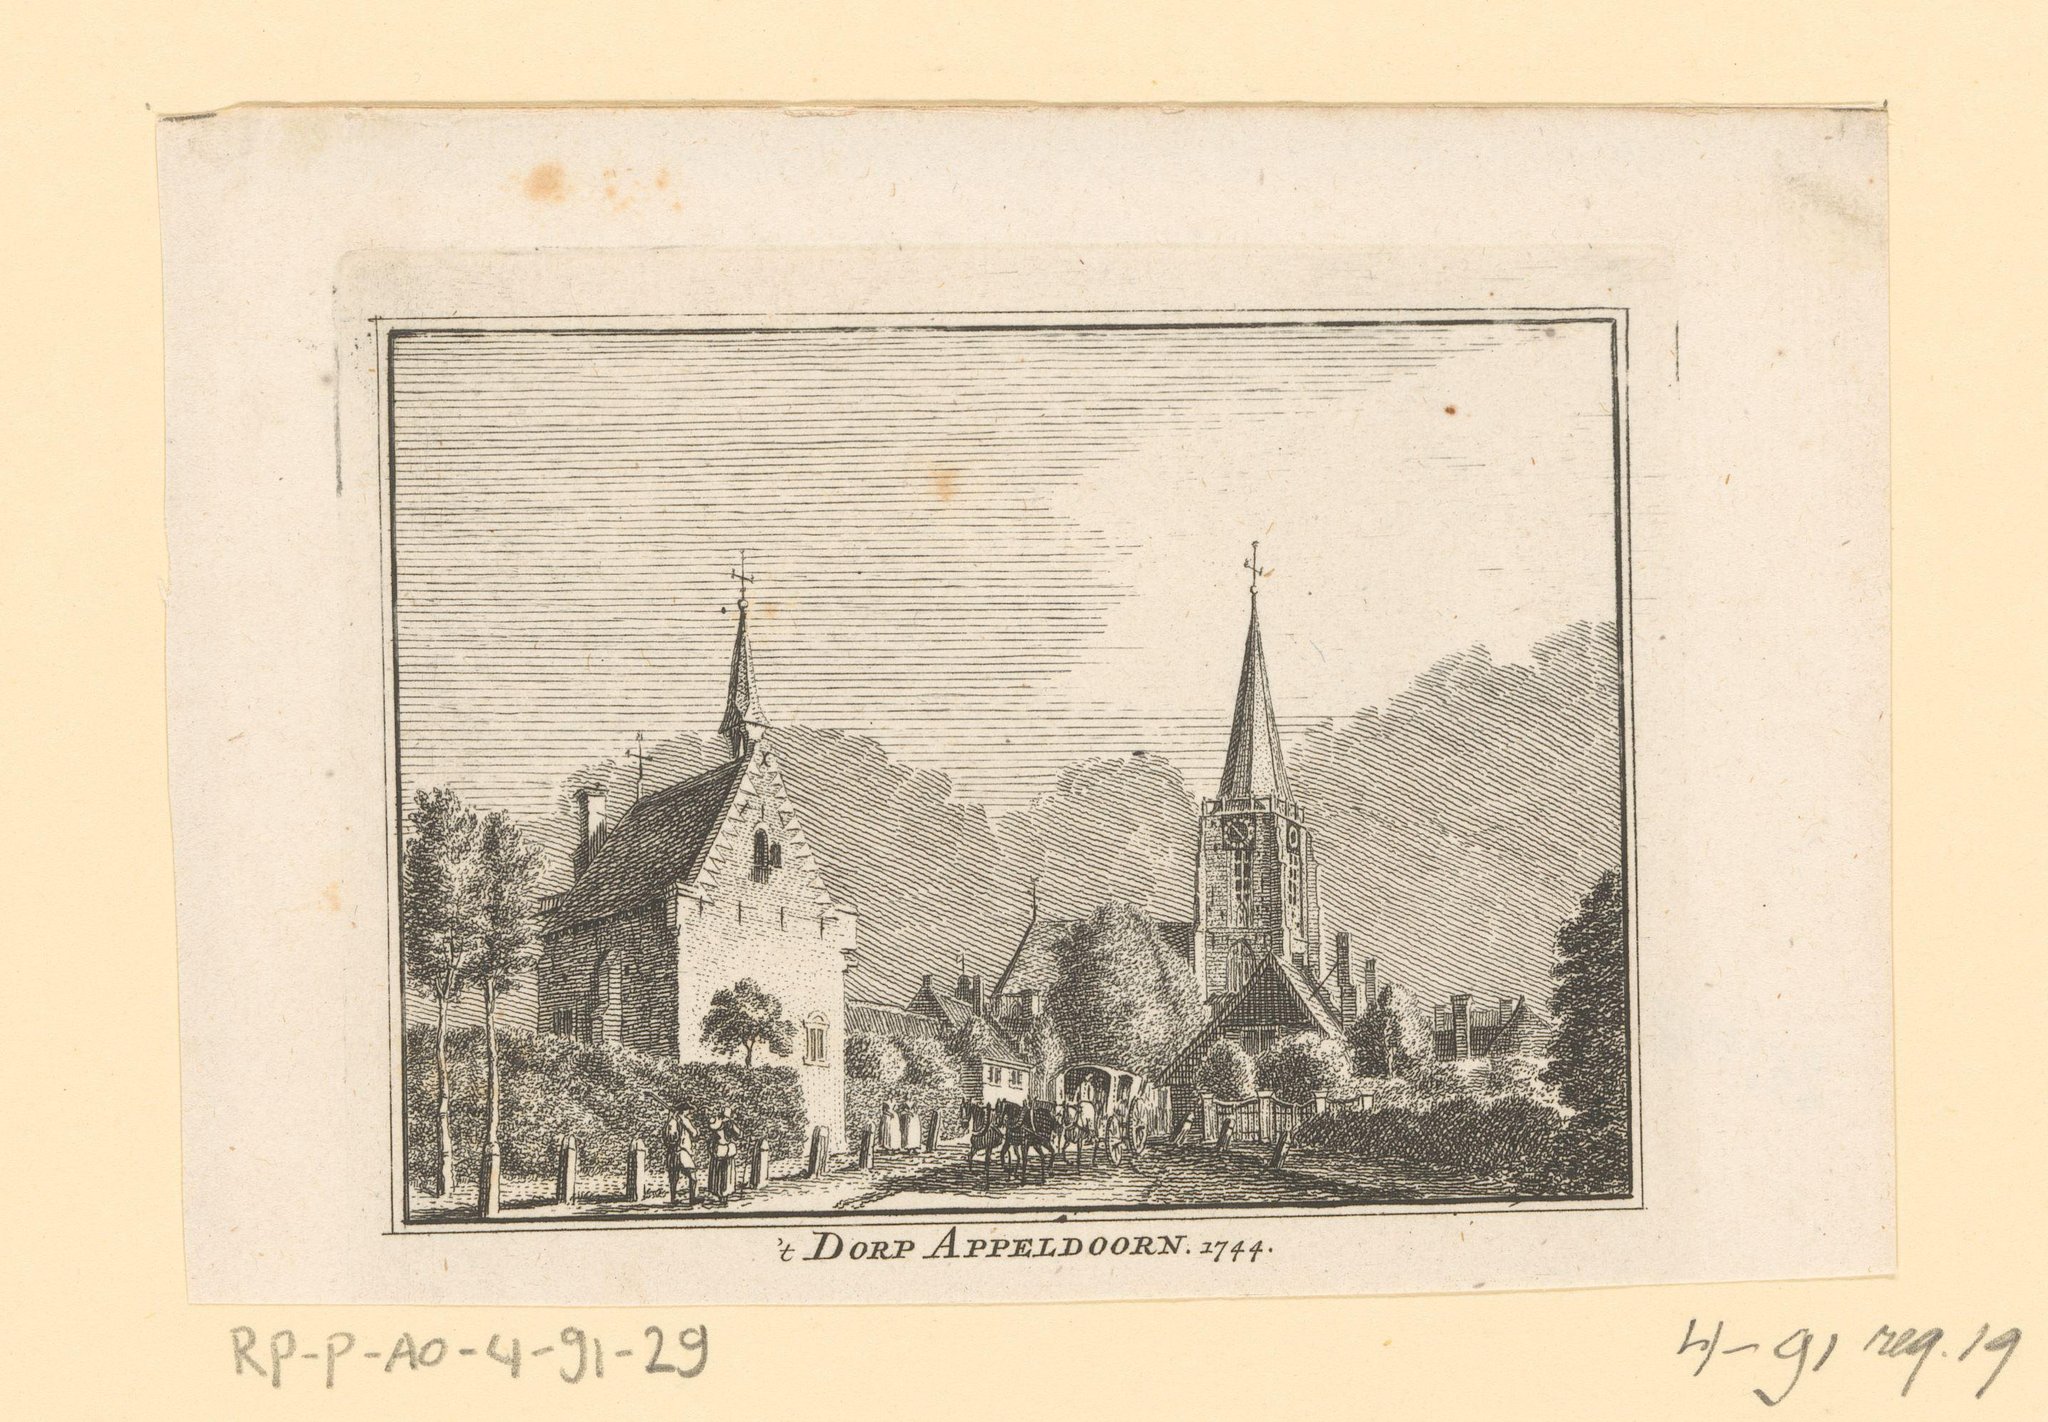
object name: print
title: Gezicht op Apeldoorn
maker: hendrik spilman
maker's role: draughtsman, painter, print maker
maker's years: 1721-1784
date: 1745-1792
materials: paper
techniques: etching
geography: haarlem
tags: prospect of village, silhouette of village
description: Prent ook gebruikt in: Het verheerlykt Nederland of kabinet van hedendaagsche gezigten van steden, dorpen (…). 9 delen. Amsterdam: Isaak Tirion en weduwe Isaak Tirion, 1745-1774, dl. 1 (1745), ill. 89. Of in: Nederlandsche tafereelen; of eene keurige verzameling van negen honderd fraaije gezigten van steden, dorpen, sloten, oudheden (….). 9 delen. Amsterdam: Jan de Groot, 1792, dl. 1, ill. 89.